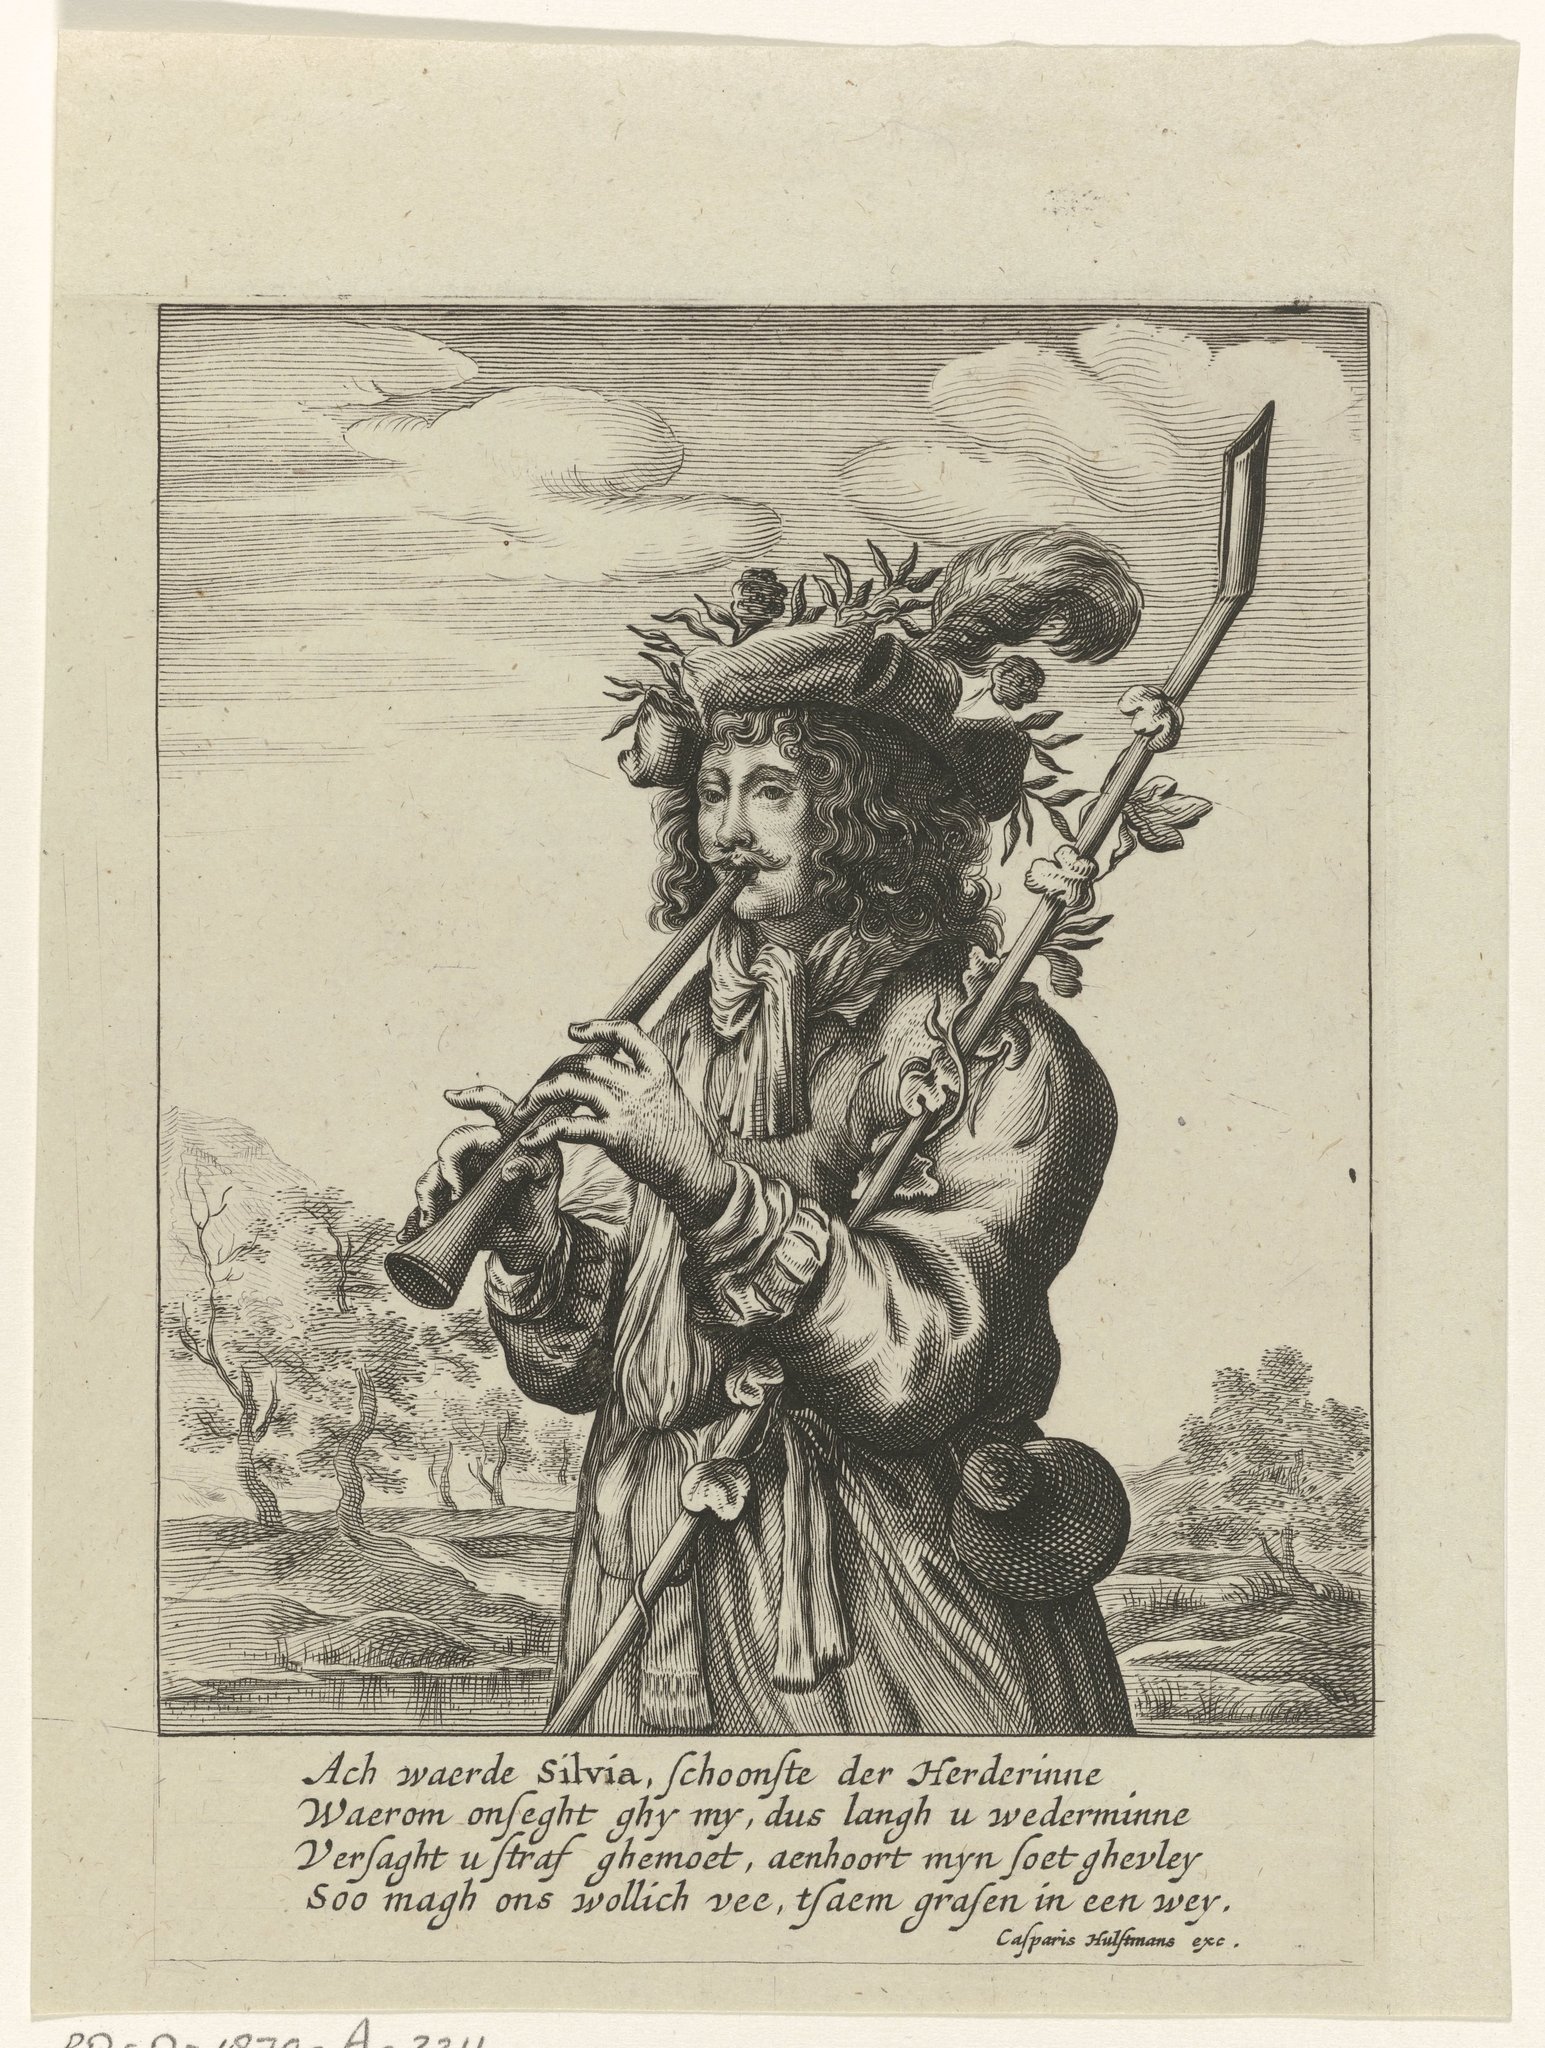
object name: print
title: Herder Coridon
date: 1600-1700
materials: paper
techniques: engraving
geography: netherlands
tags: flute, aulos, tibia - cc - out of doors, pastorals, arcadian scenes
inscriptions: collector's mark: Lugt 2228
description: De herder Coridon bespeelt de fluit en probeert zo zijn geliefde Sylvia te vleien. Onder de voorstelling een vierregelig vers in het Nederlands.